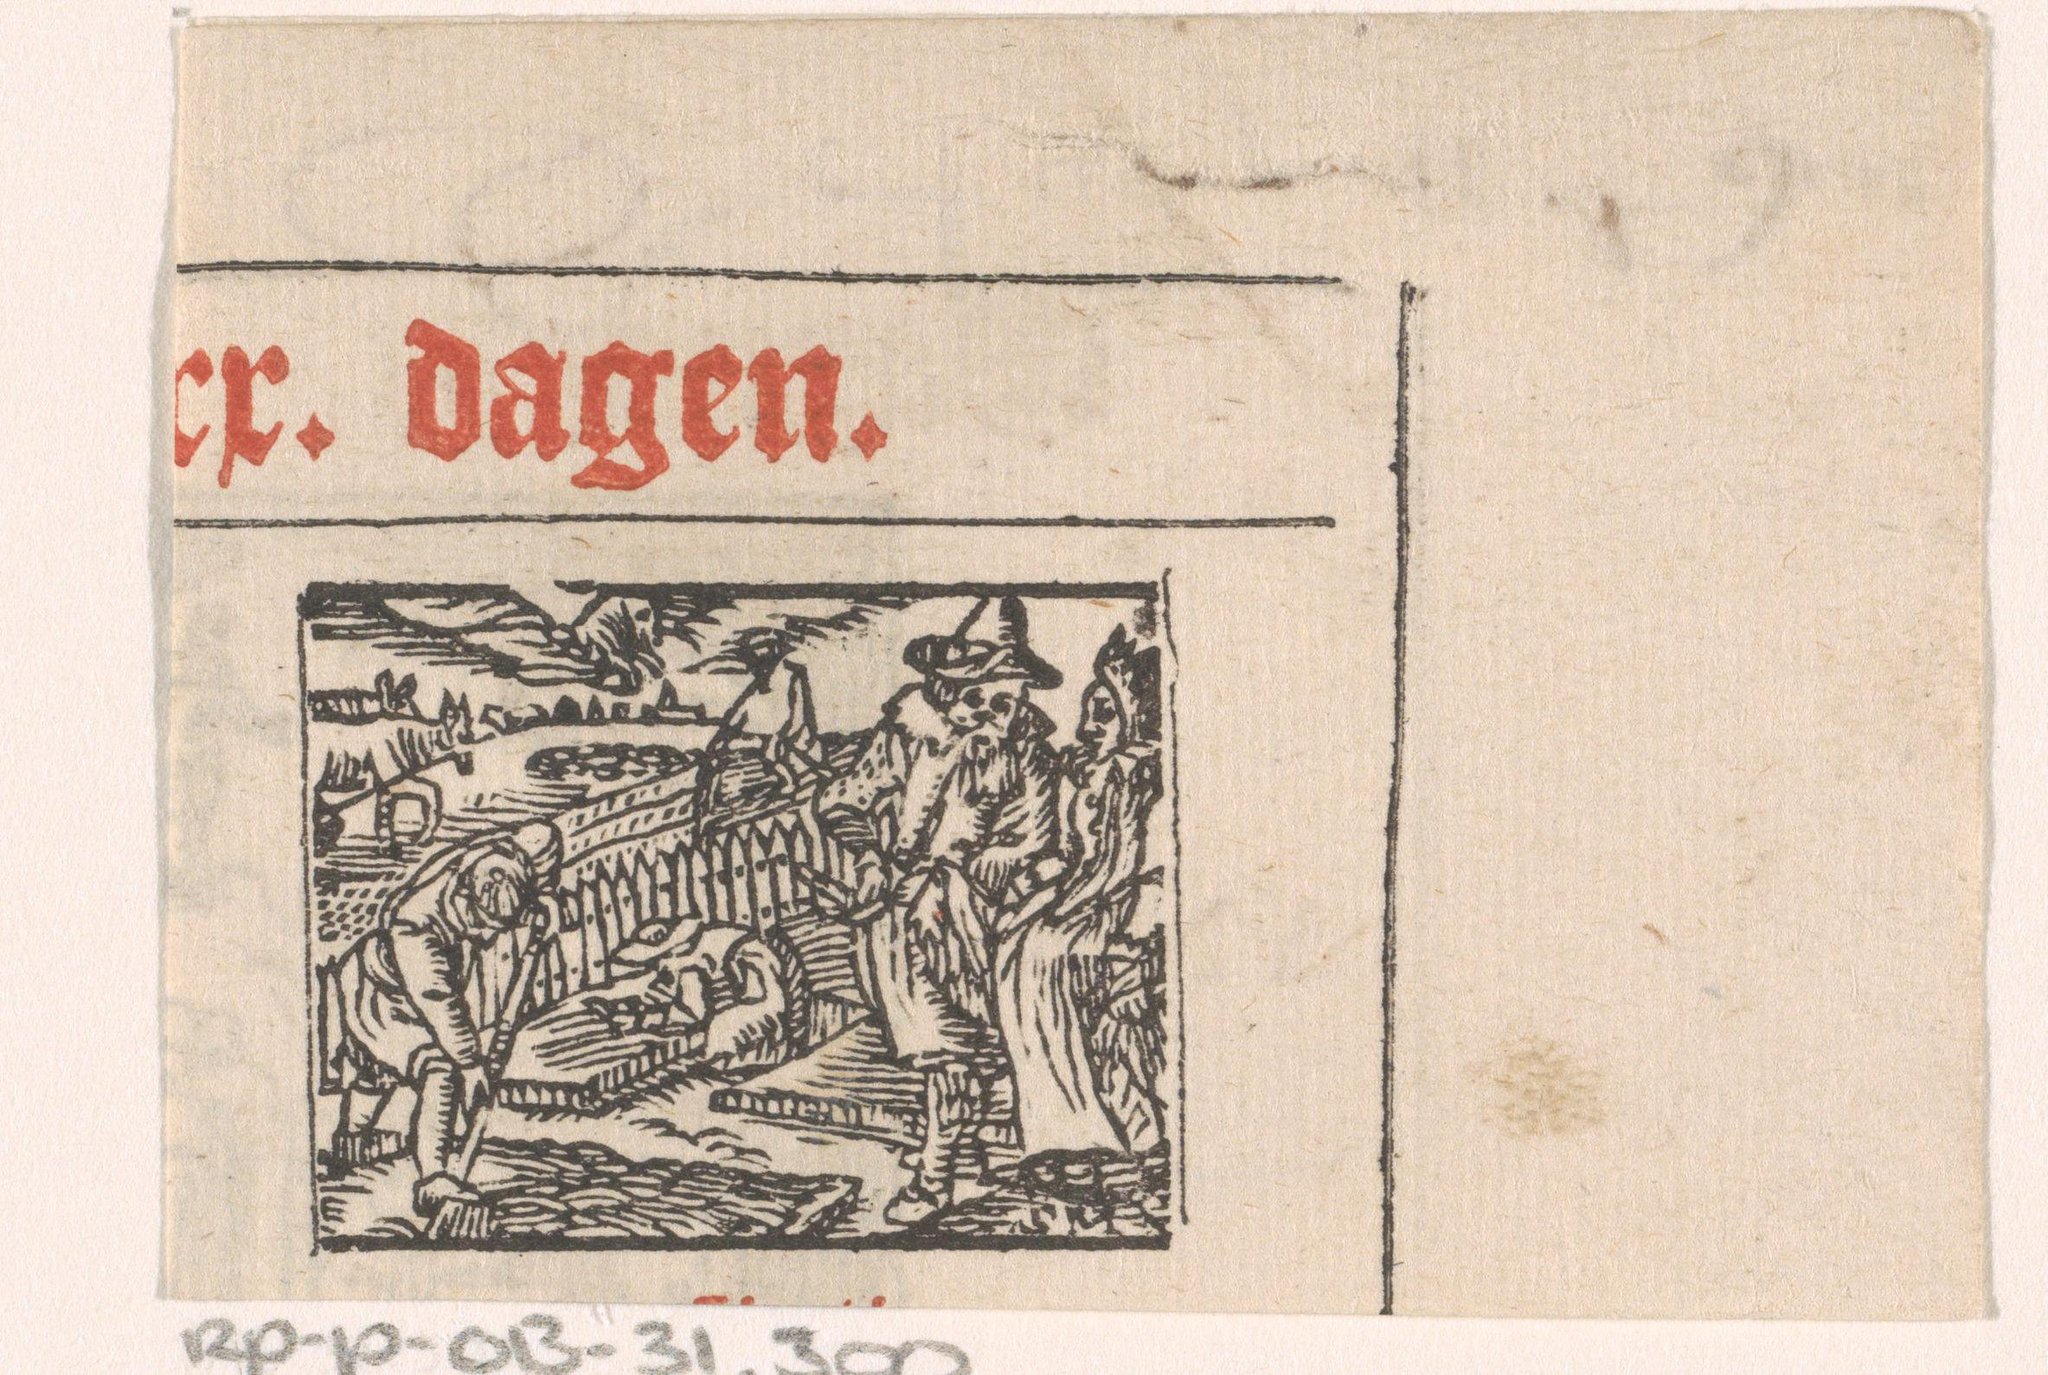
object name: print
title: Figuren werkend in een omheinde tuin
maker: monogrammist sm (18e eeuw)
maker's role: print maker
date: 1700-1799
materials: paper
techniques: letterpress printing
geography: northern netherlands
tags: standing figure, the twelve months represented by scenes showing human activities, usually in a landscape; so-called 'labours of the months', garden, kneeling figure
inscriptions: collector's mark: Lugt 2228